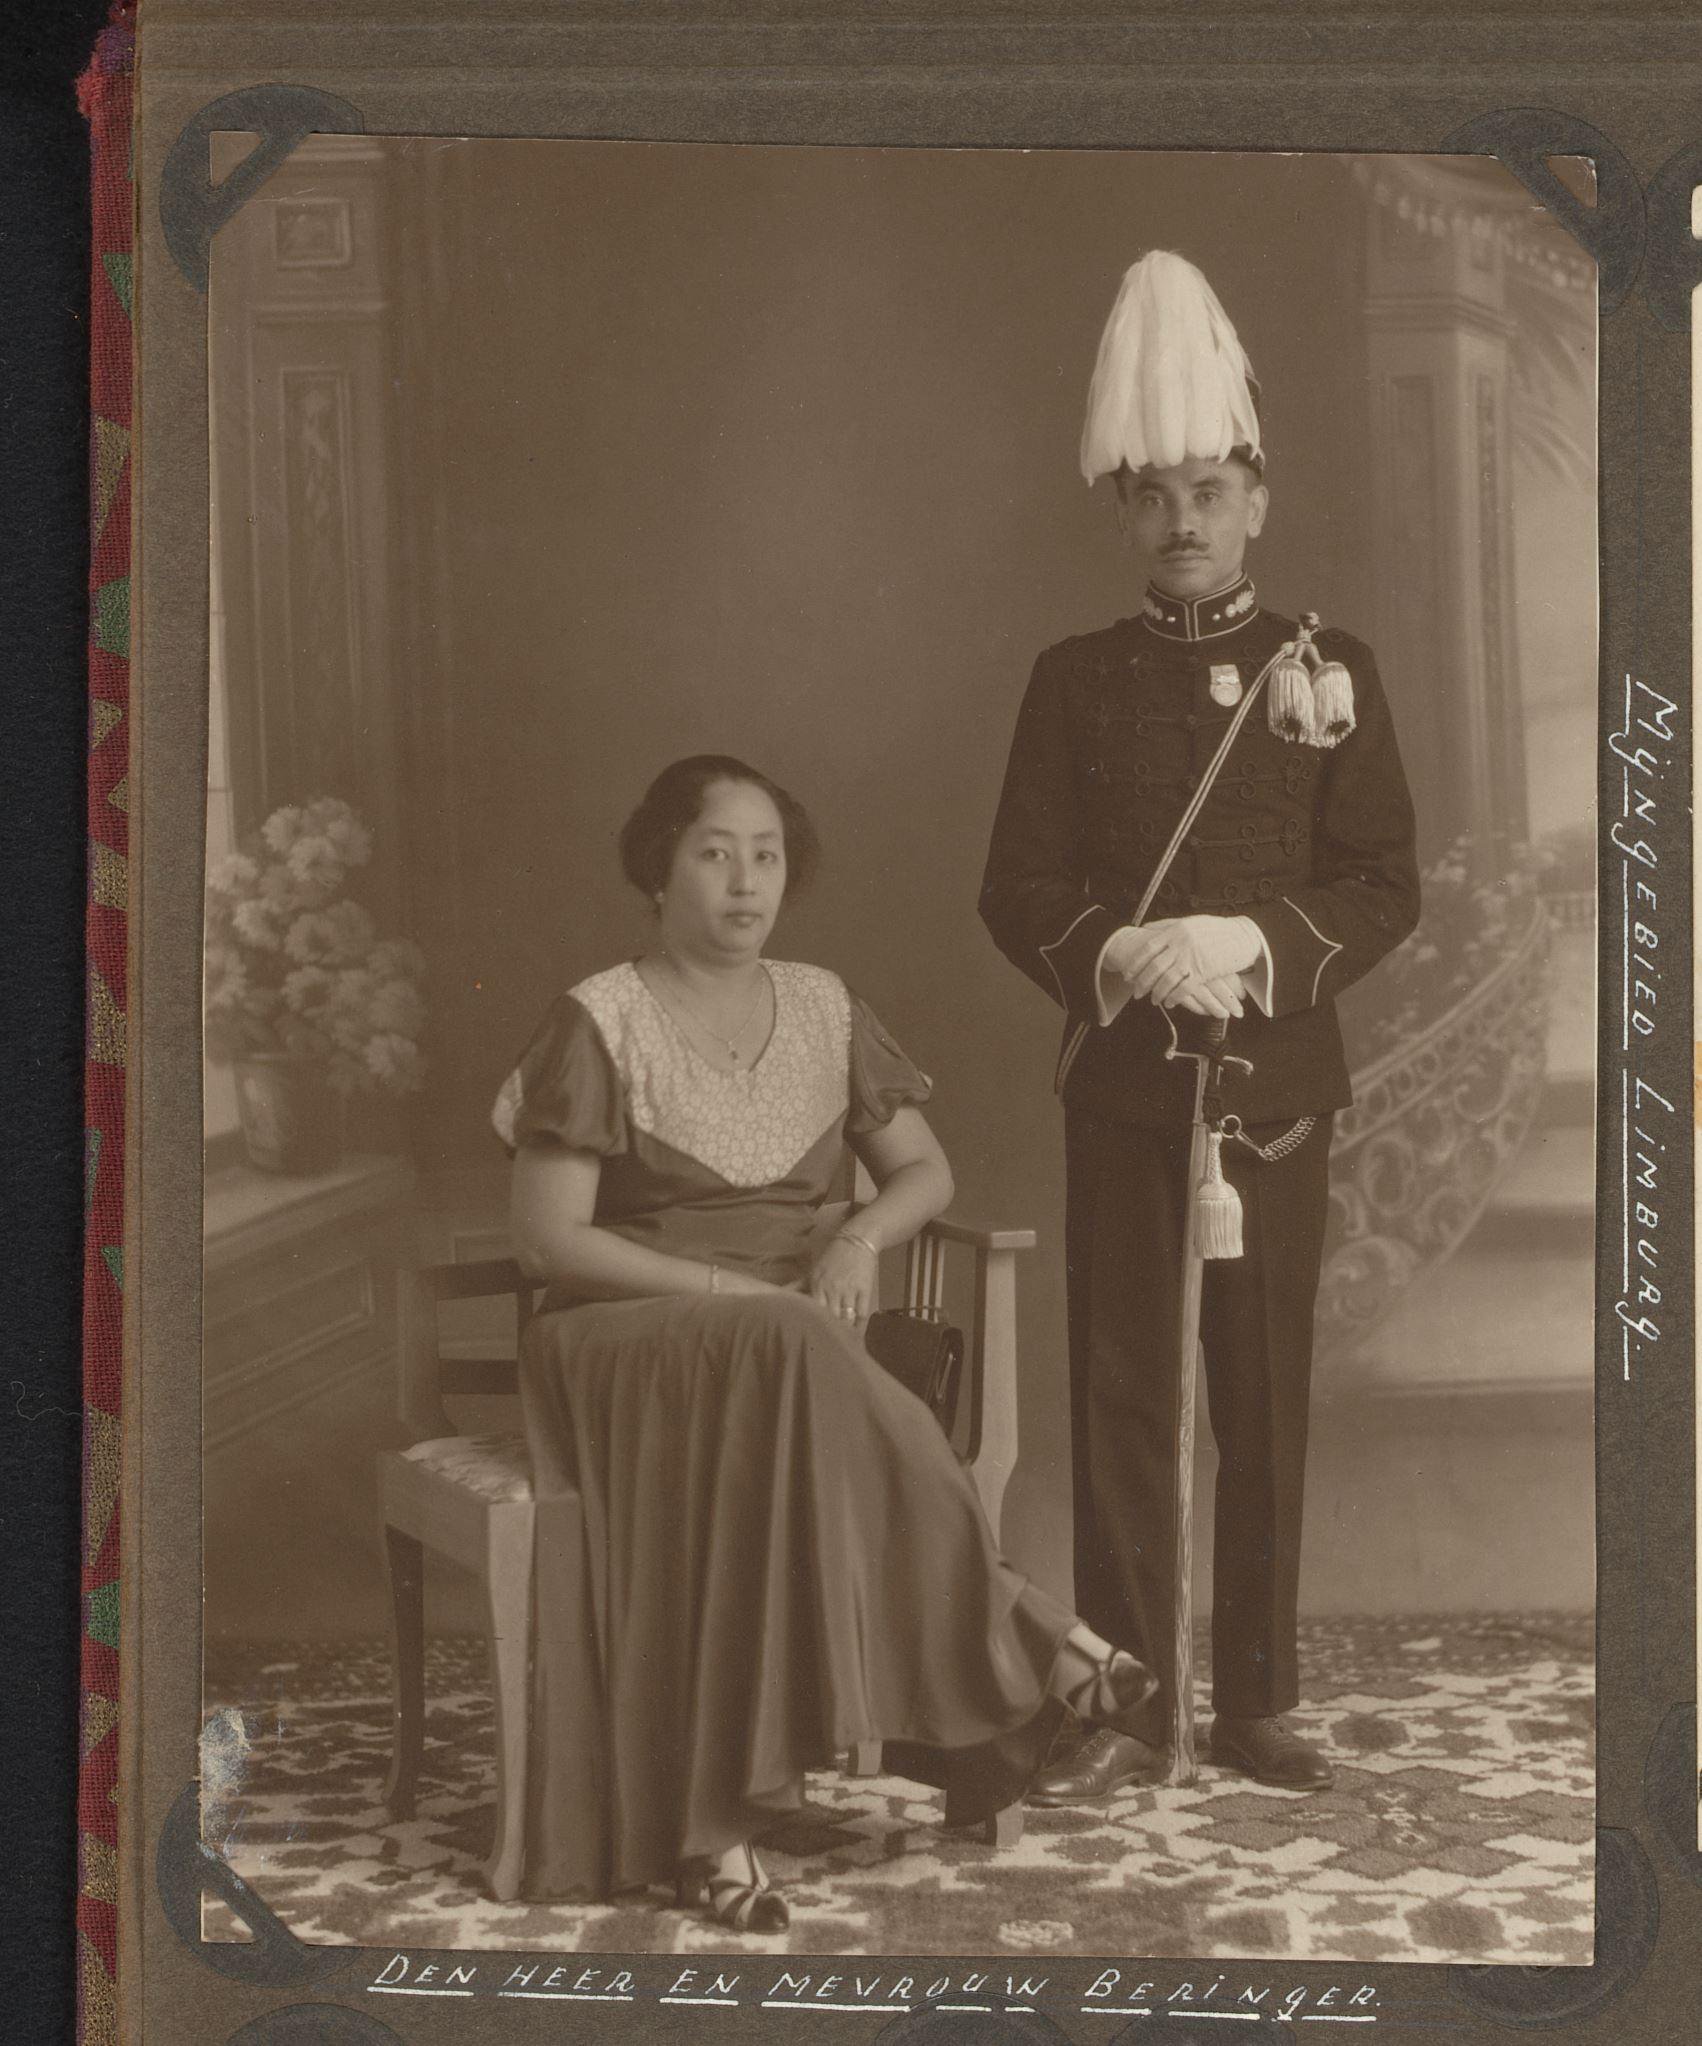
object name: photograph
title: Heer en mevrouw Beringer, 1933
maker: Anonymous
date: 1933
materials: photographic support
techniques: gelatin silver print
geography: malang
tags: douwe de vries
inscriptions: inscription: ‘Den heer en mevrouw Beringer.’, inscription: ‘opgen: 17-9-'33. Echtpaar Beringer.’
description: Studioportret van het echtpaar Beringer, Indische vrienden van het echtpaar De Vries in Malang, 17 september 1933. Onderdeel van het fotoalbum van KNIL-sergeant Douwe de Vries uit de jaren 1925-1933.